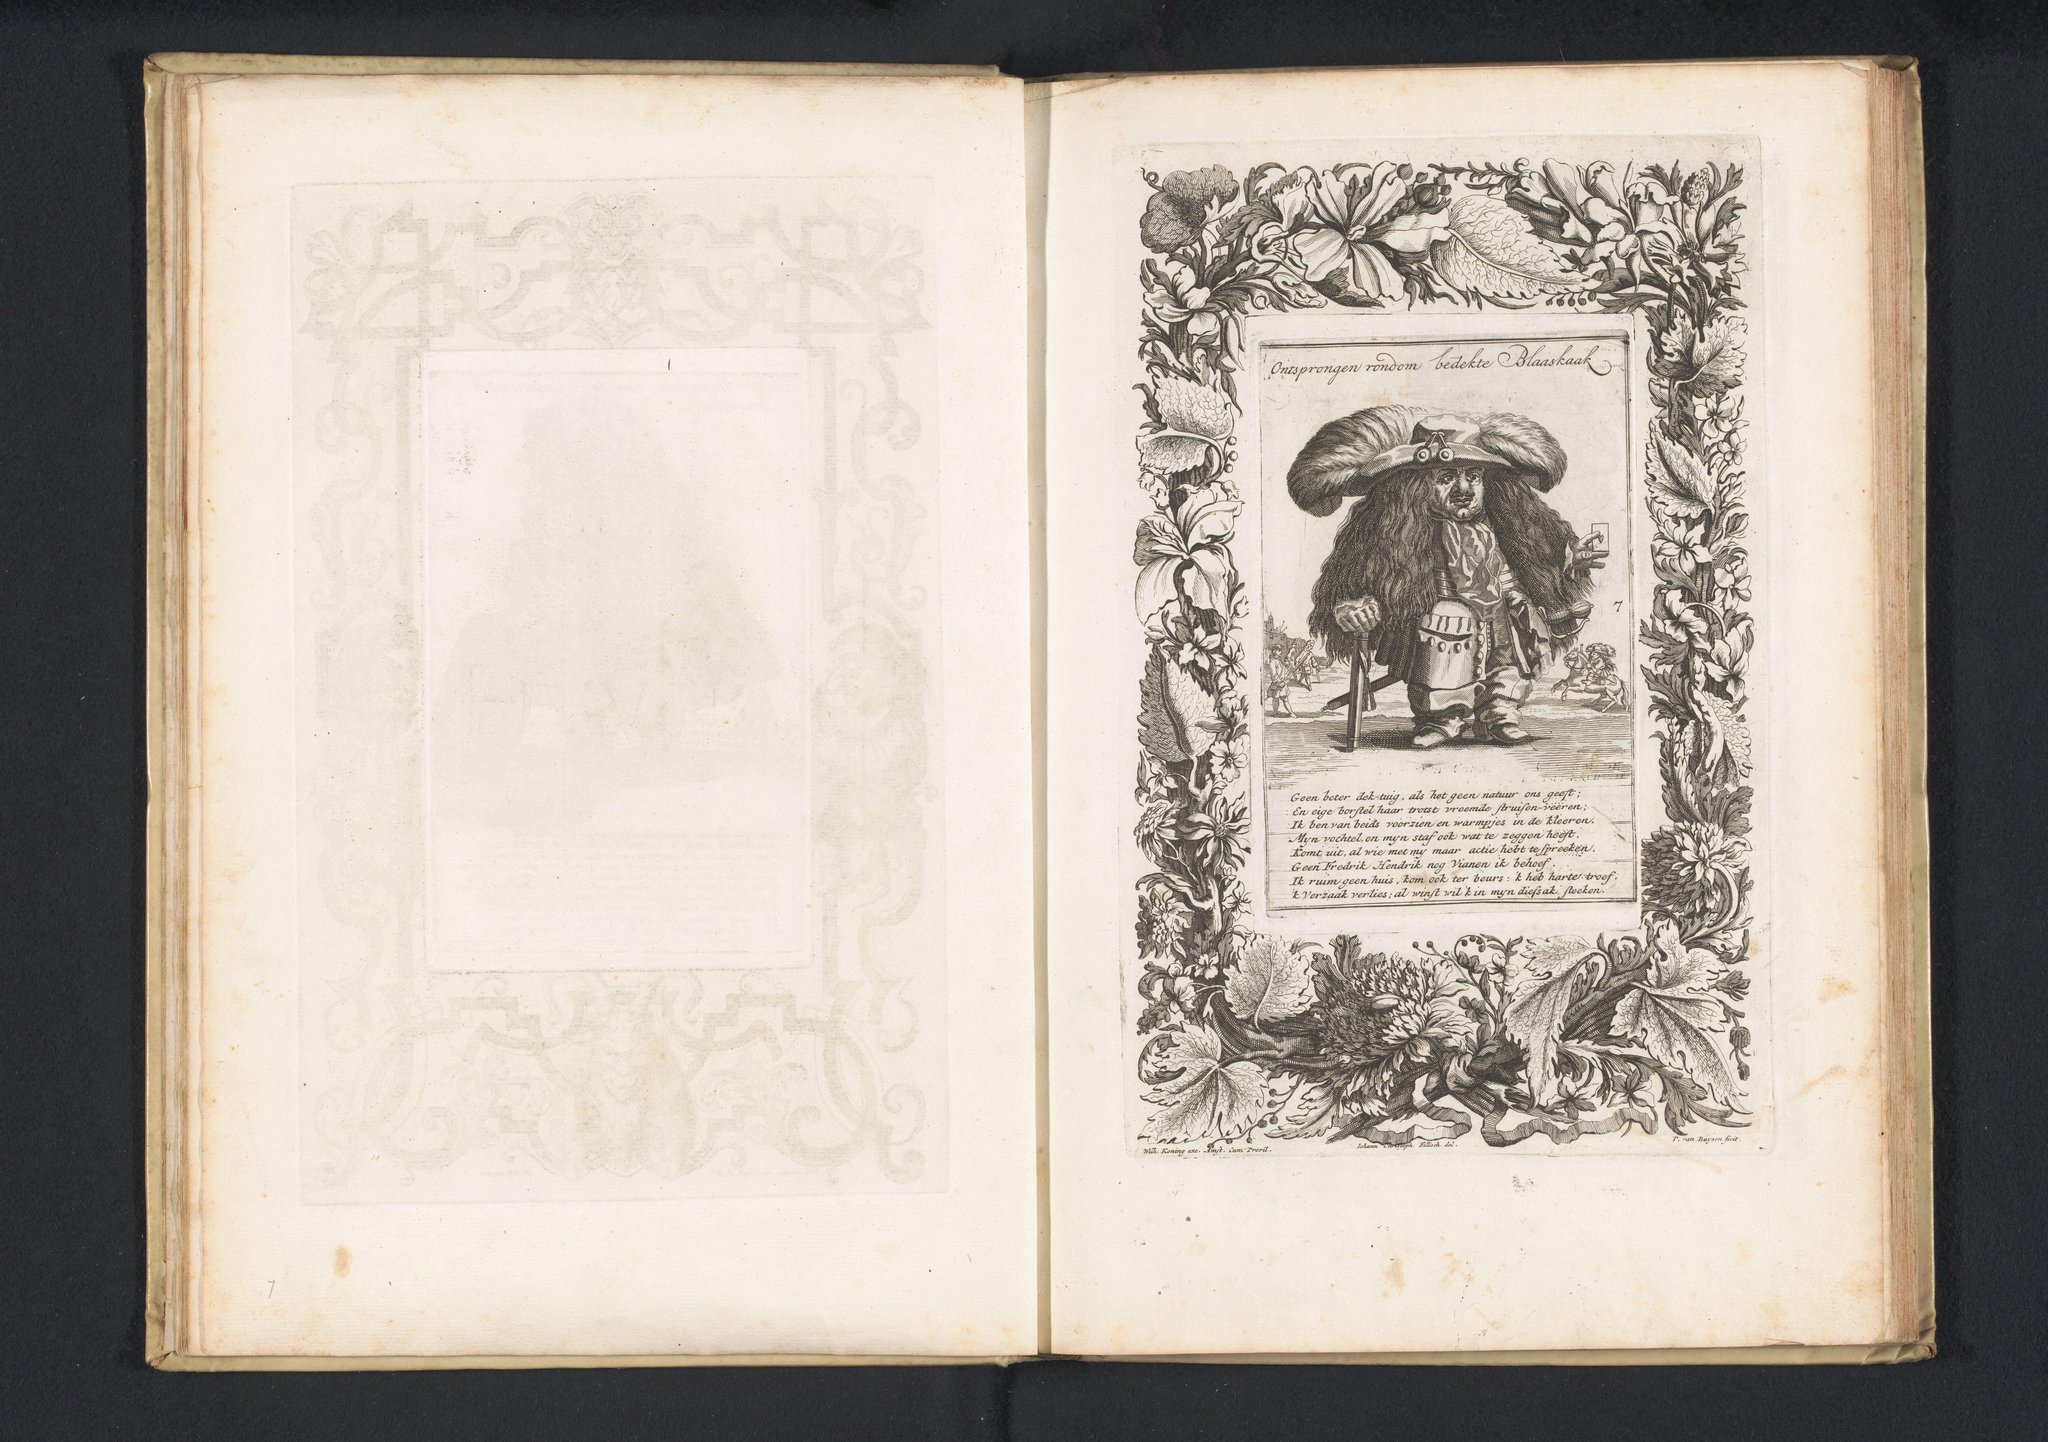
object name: caricature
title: Dwerg als officier met grote verenhoed en een speelkaart in de hand, 1720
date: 1716-1720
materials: paper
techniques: etching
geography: northern netherlands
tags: caricatures (human types), little people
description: Een kleine mens als officier met grote verenhoed en een speelkaart in de hand. In het onderschrift een vers in het Nederlands. Genummerd rechts midden: 7. Afdruk binnen een decoratieve omlijsting gedrukt van een aparte plaat met bloemen. Onderdeel van de tweede Nederlandse gebonden uitgave uit 1720 (en gerelateerd aan de Windhandel in dat jaar) van een serie karikaturen van kleine mensen, bekend als Het Dwergentooneel, deels gekopieerd naar een ouder Duits voorbeeld.